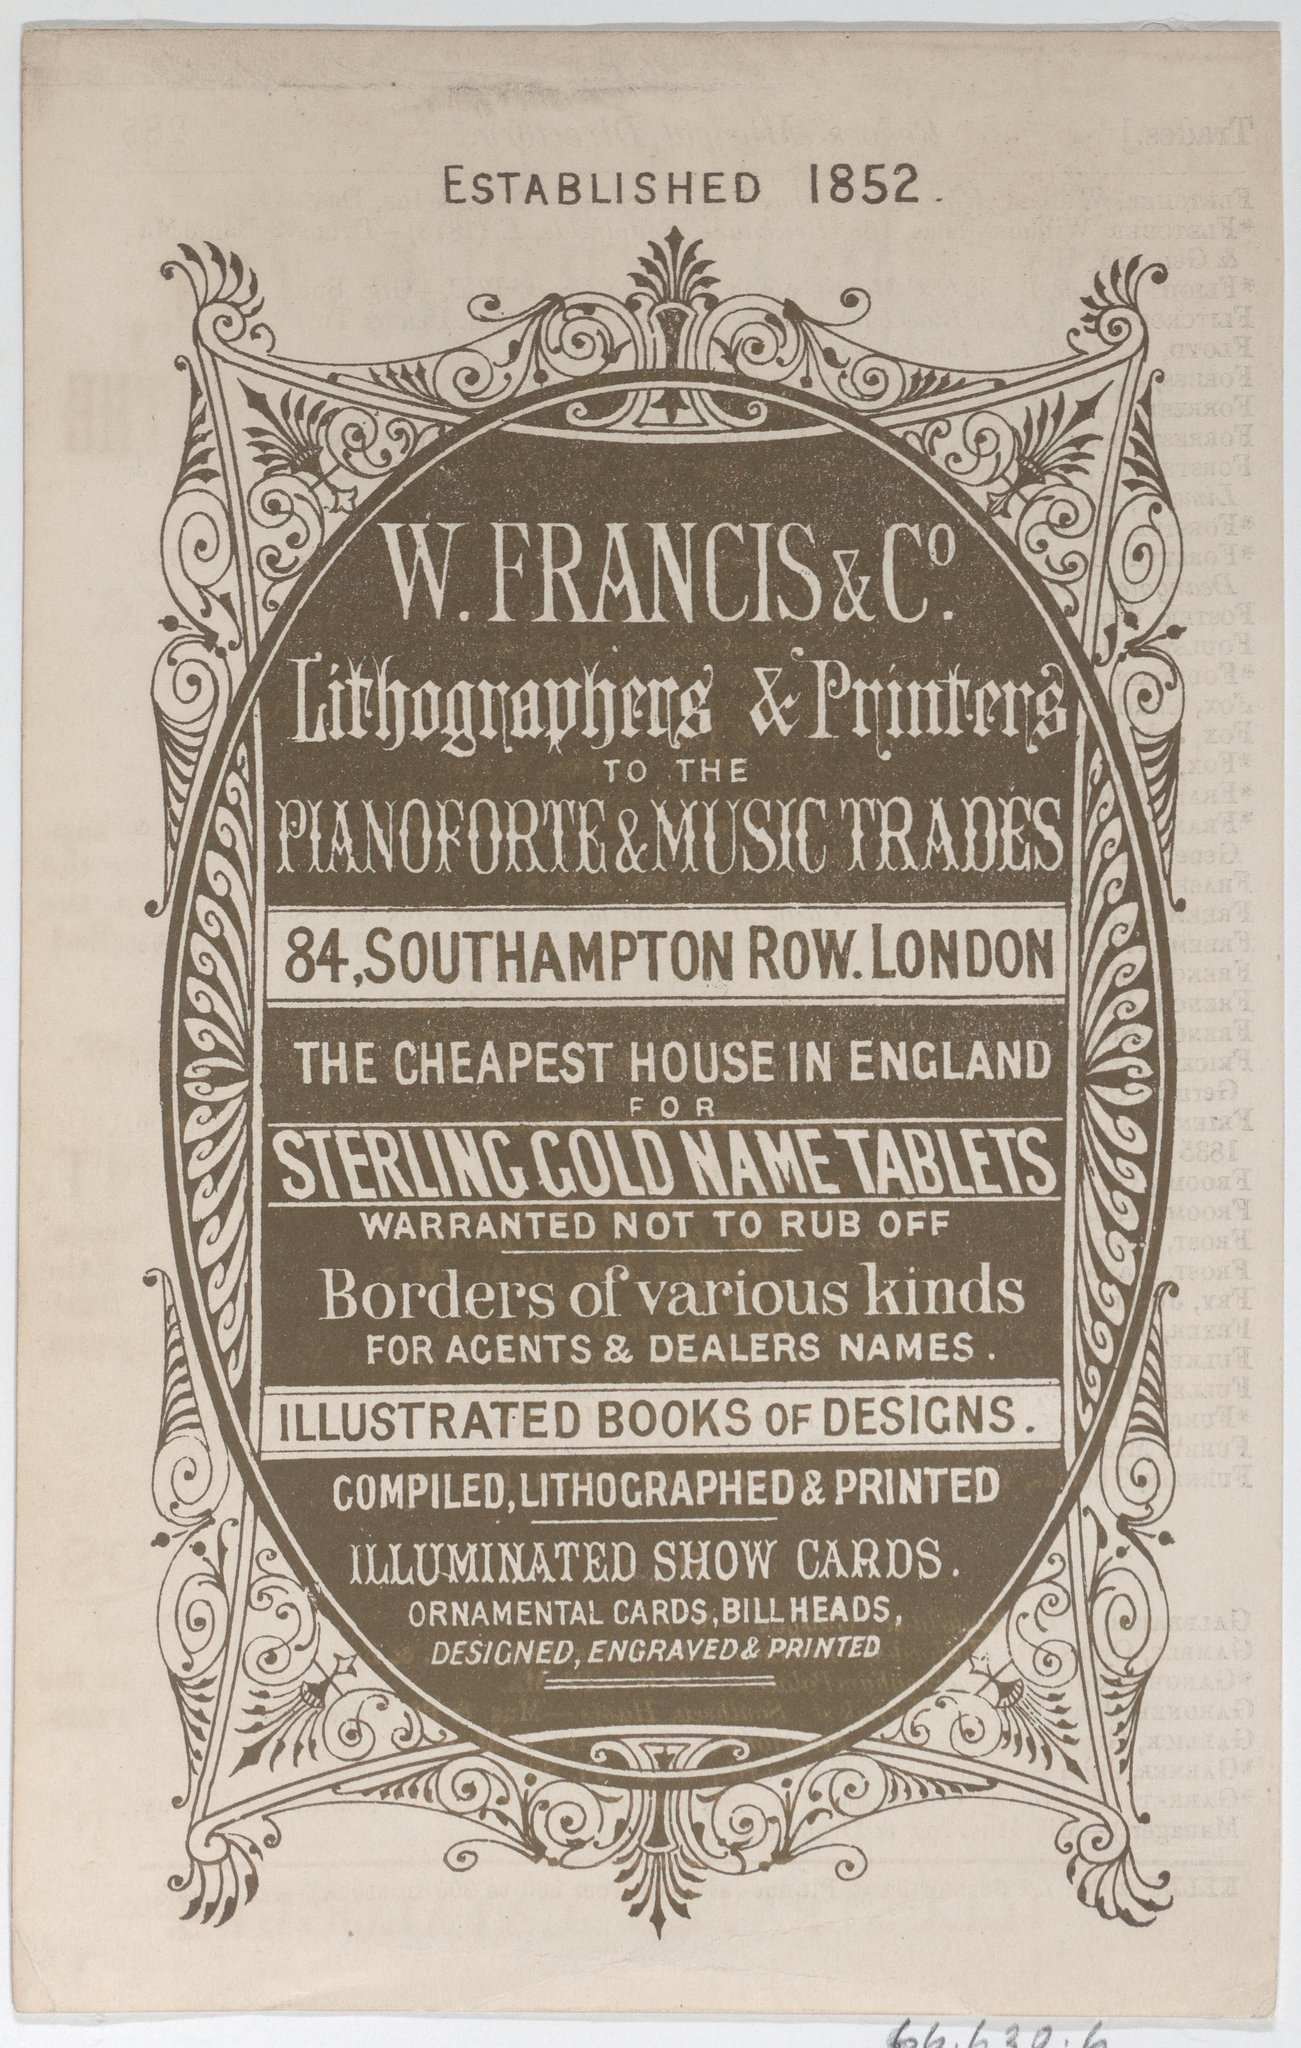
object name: print, trade card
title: Trade Card for W. Francis & Co., Lithographers and Printers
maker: anonymous, british, 19th century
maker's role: artist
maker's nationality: british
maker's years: 1800-1900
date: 1801-1900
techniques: lithography